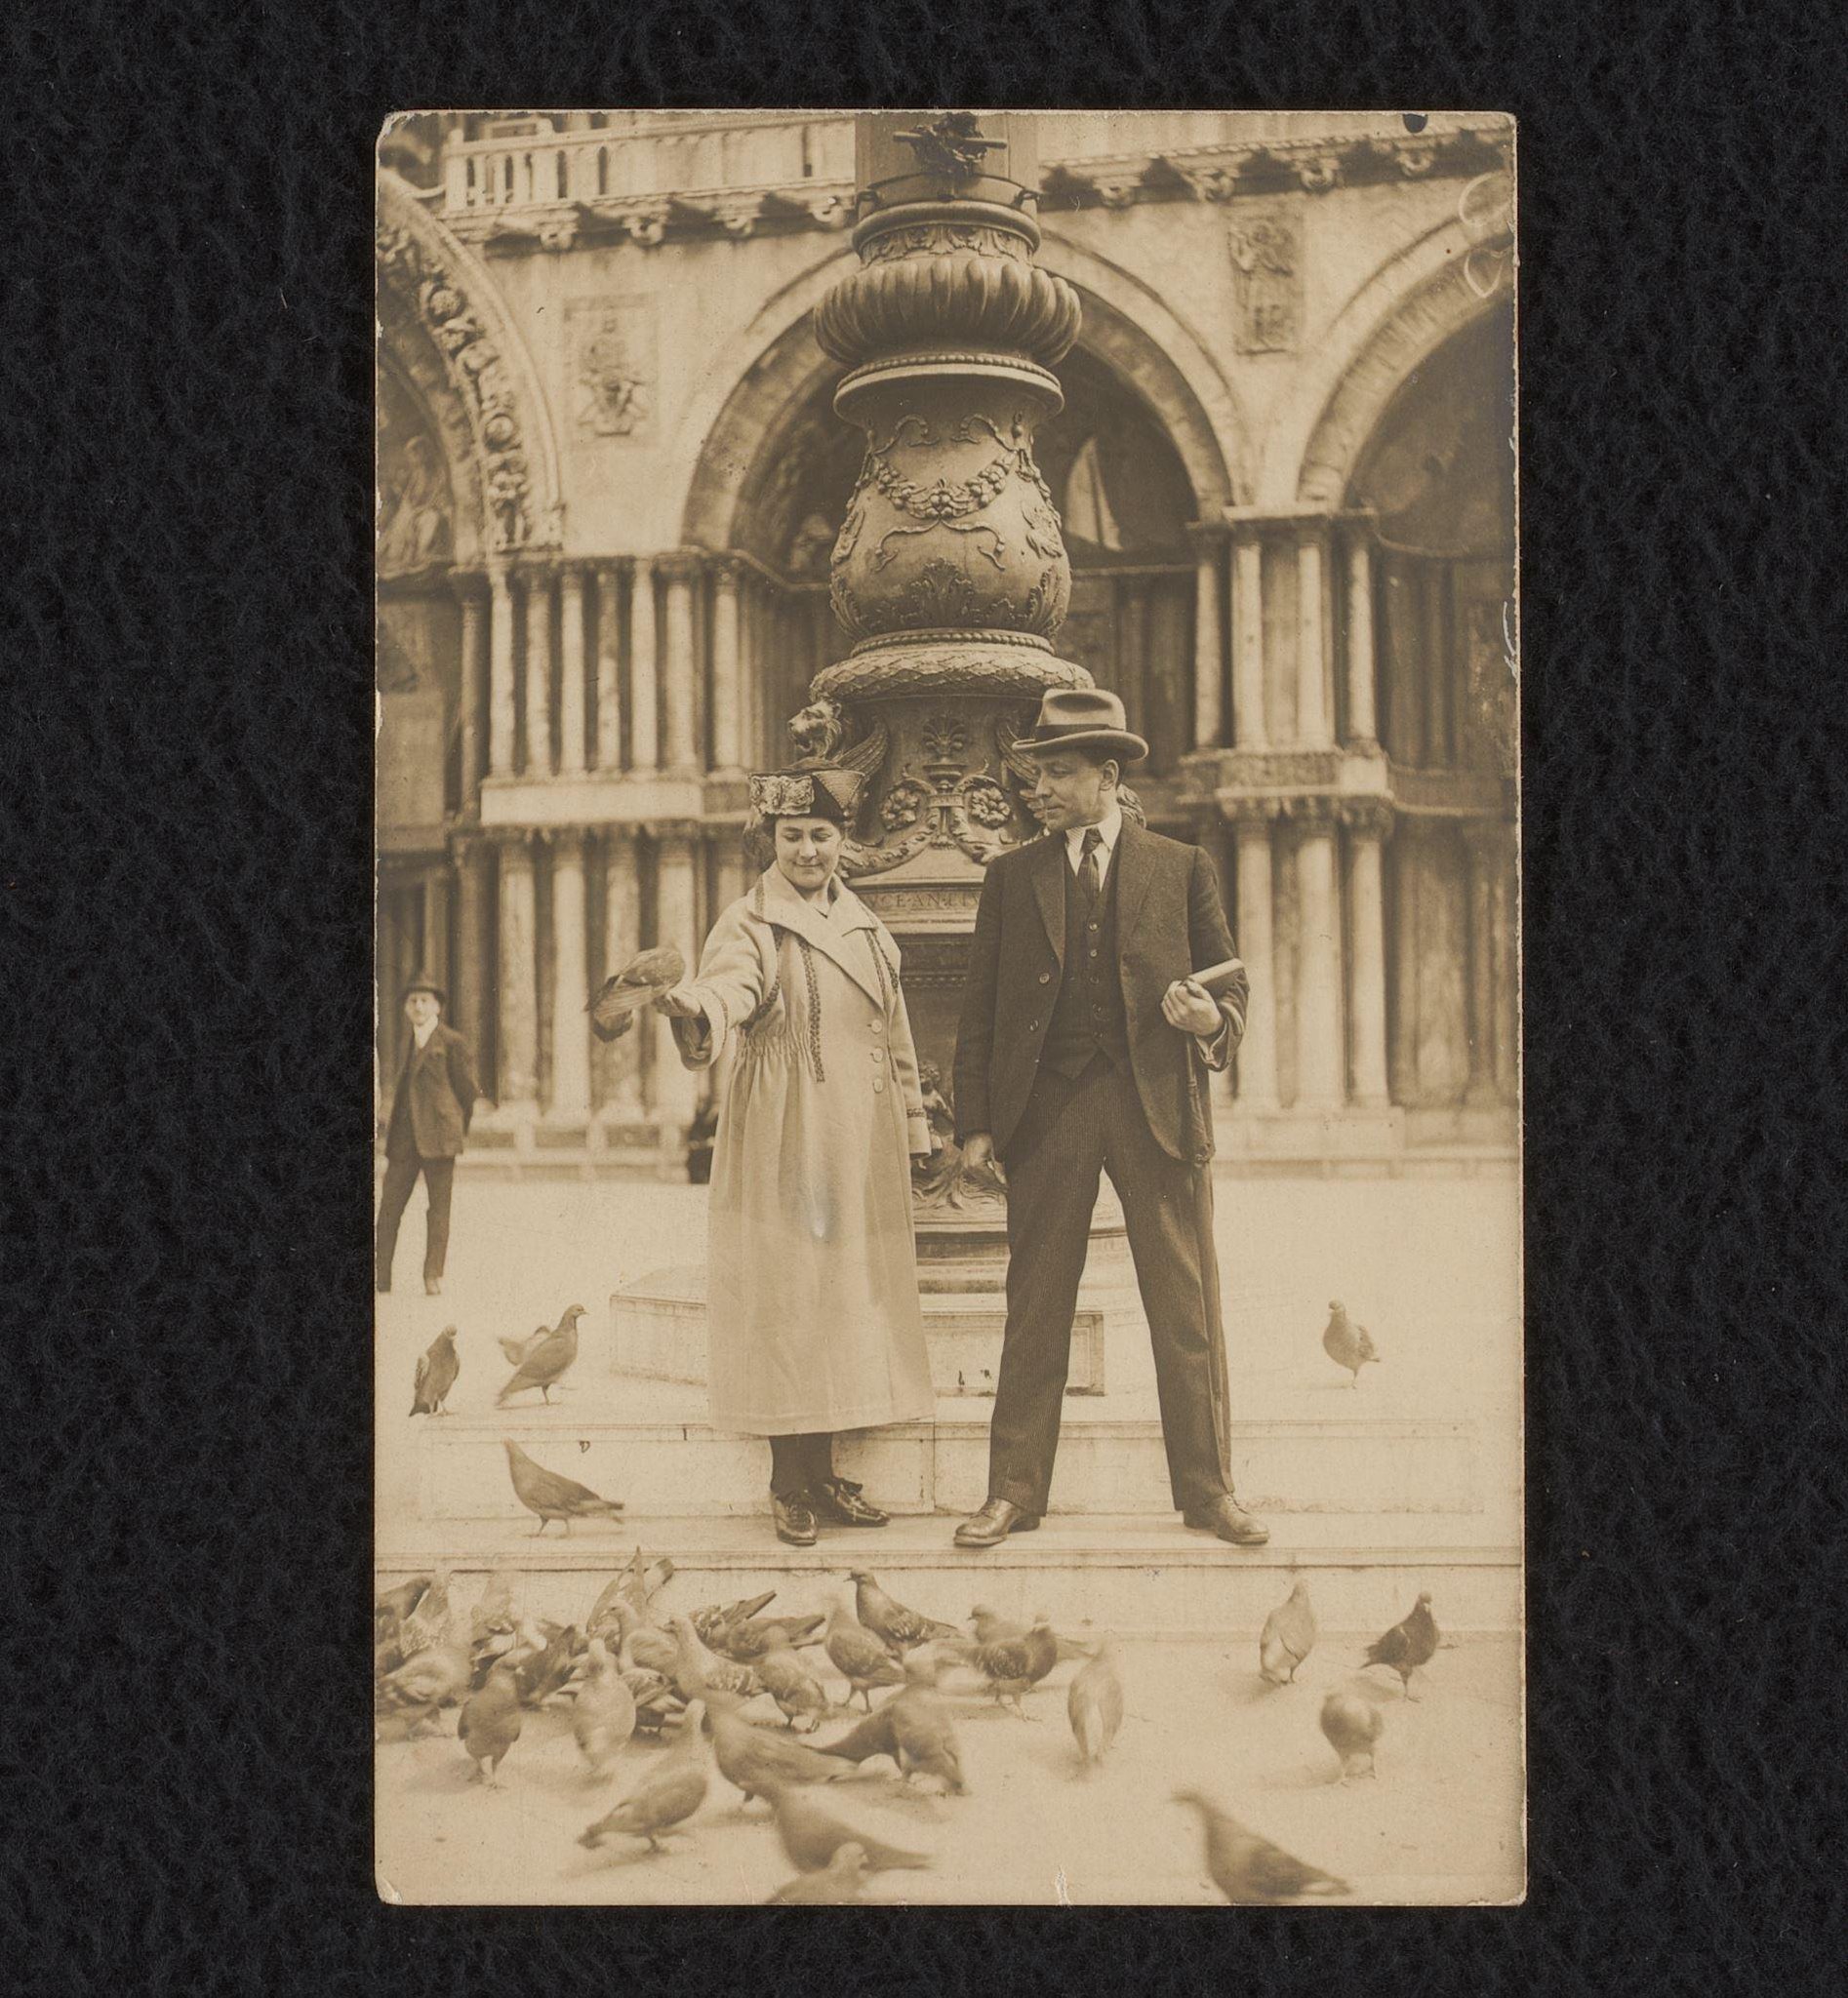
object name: ansichtkaart, prentbriefkaart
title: Petronella Bon en Wilhelmus Scheffer op het San Marcoplein in Venetië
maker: Anonymous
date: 1912-1920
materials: paper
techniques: gelatin silver print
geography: venice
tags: square, place, circus, etc., historical persons, doves, pigeons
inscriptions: inscription: ‘Tante Nel en Oom Wim in/ Venetië’